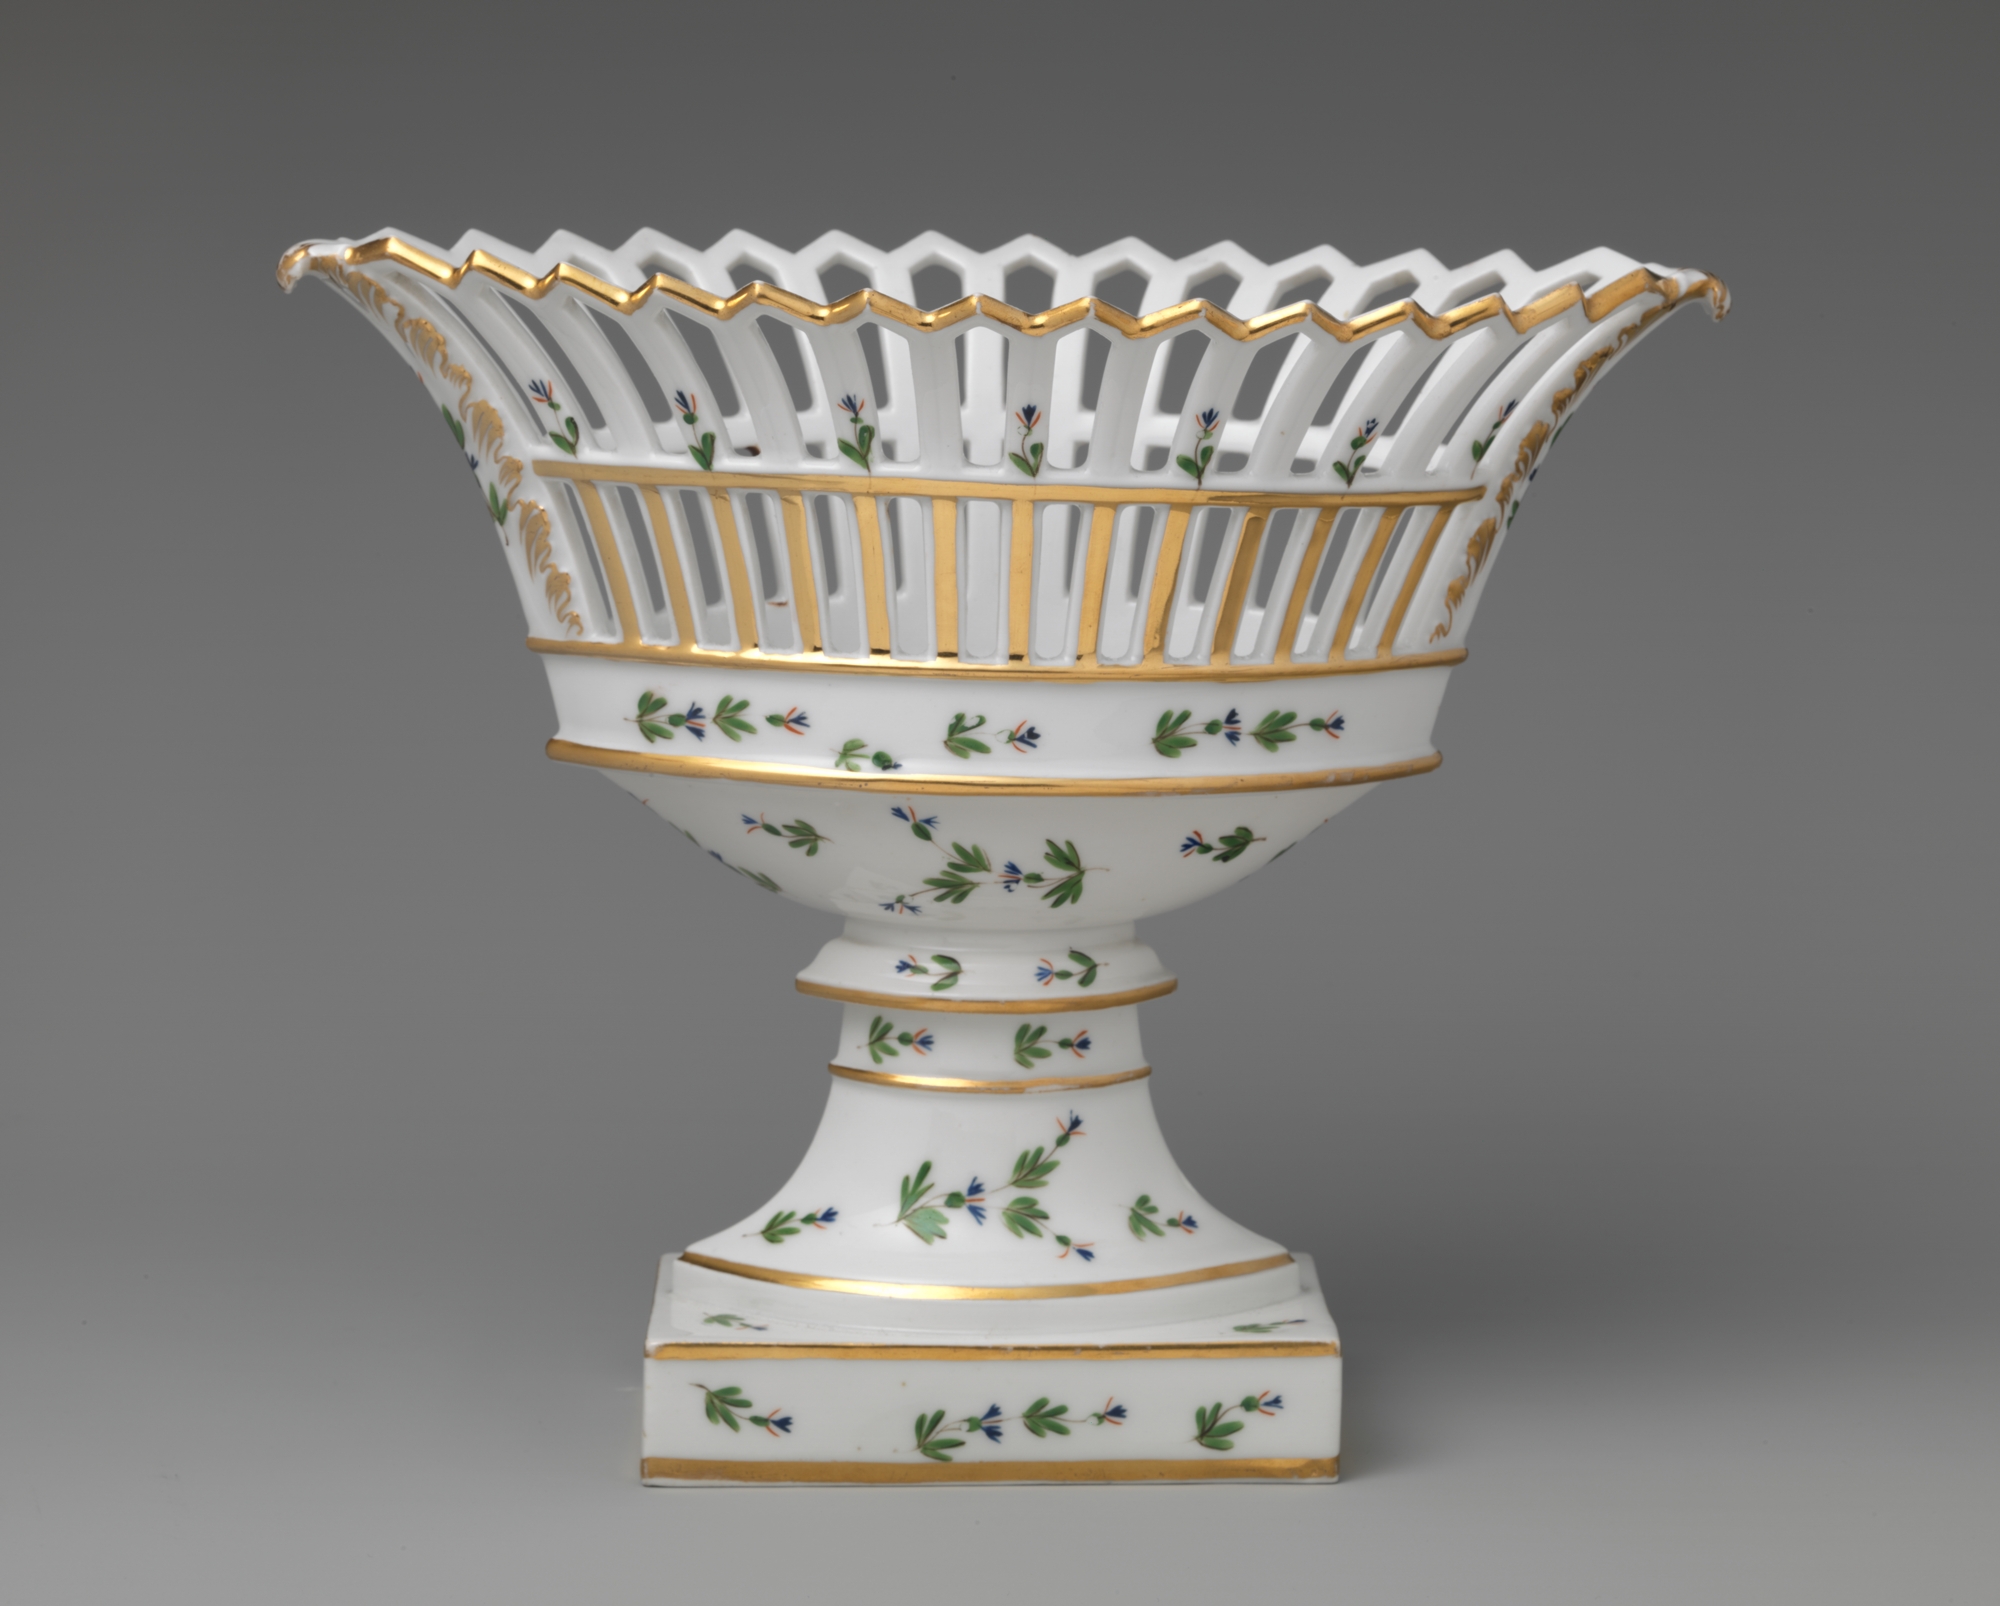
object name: compote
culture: french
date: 1815-1830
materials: porcelain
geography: france